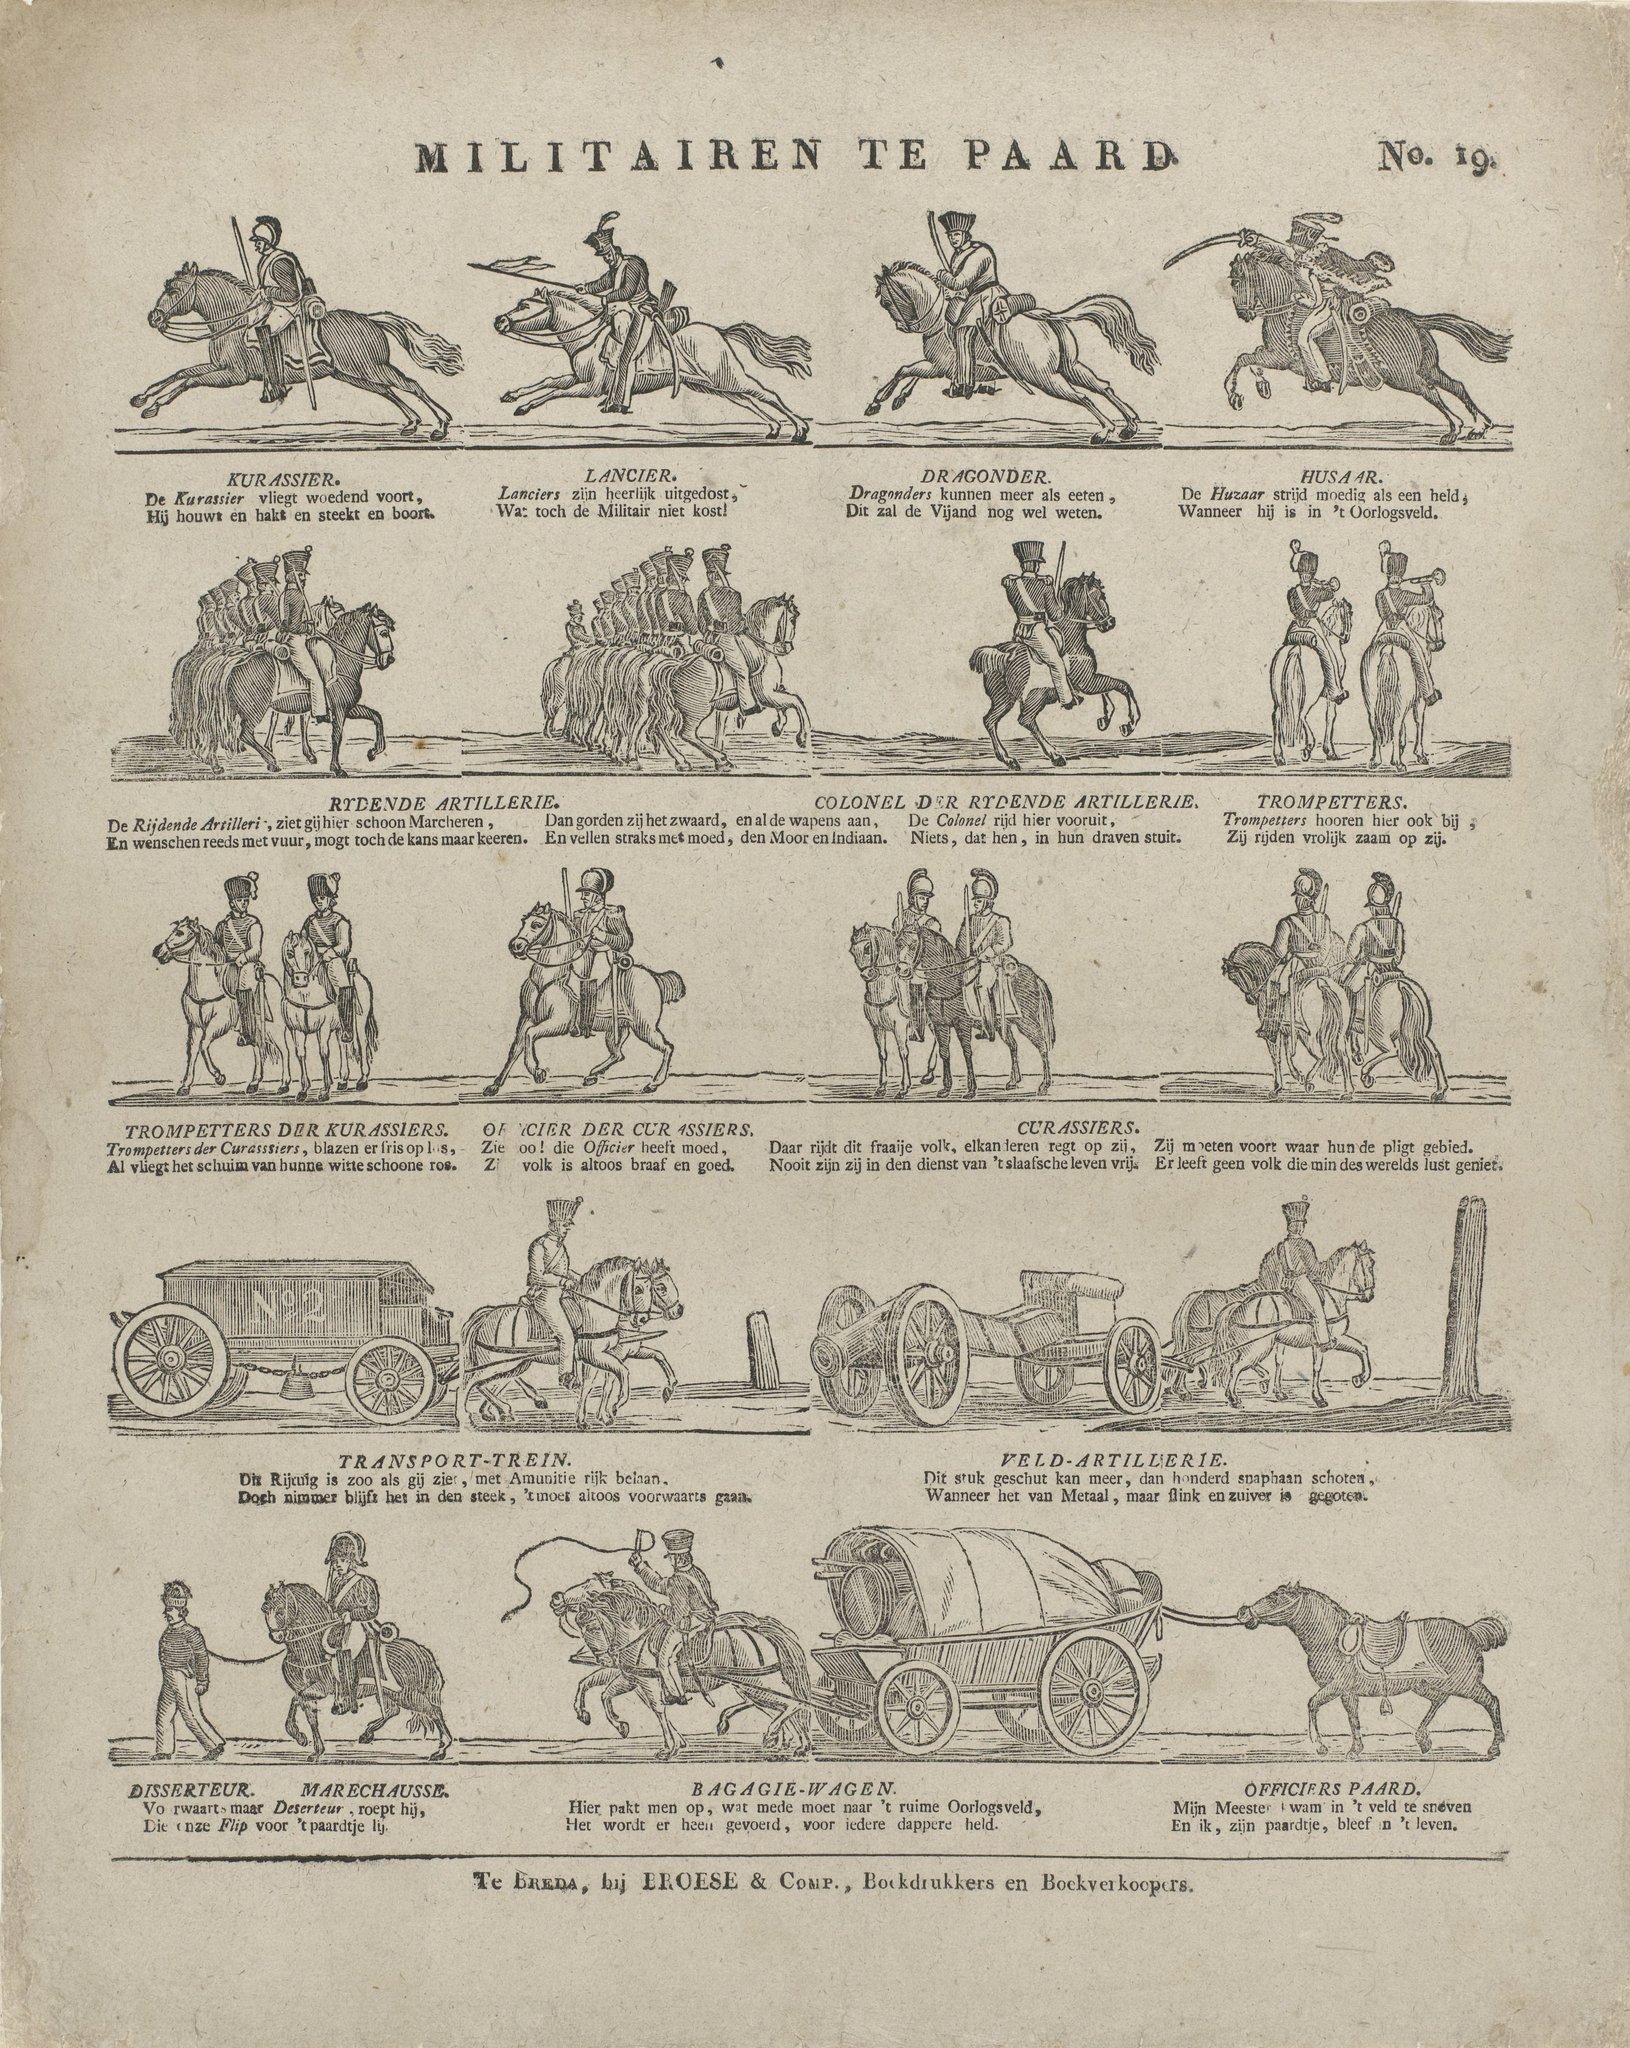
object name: print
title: Militairen te paard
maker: Anonymous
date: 1828-1853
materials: paper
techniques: letterpress printing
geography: breda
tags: four-wheeled, animal-drawn vehicle, e.g.: cab, carriage, coach, warfare; military affairs (+ cavalry, horsemen)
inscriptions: collector's mark: Lugt 2760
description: Blad met 5 horizontale rijen met voorstellingen van militairen te paard en militairen met paard en wagen. Onder elke voorstelling een onderschrift. Genummerd rechtsboven: No. 19.